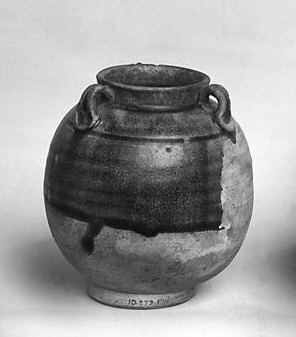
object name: jar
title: Jar with three lugs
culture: chinese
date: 567-633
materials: glaze, stoneware